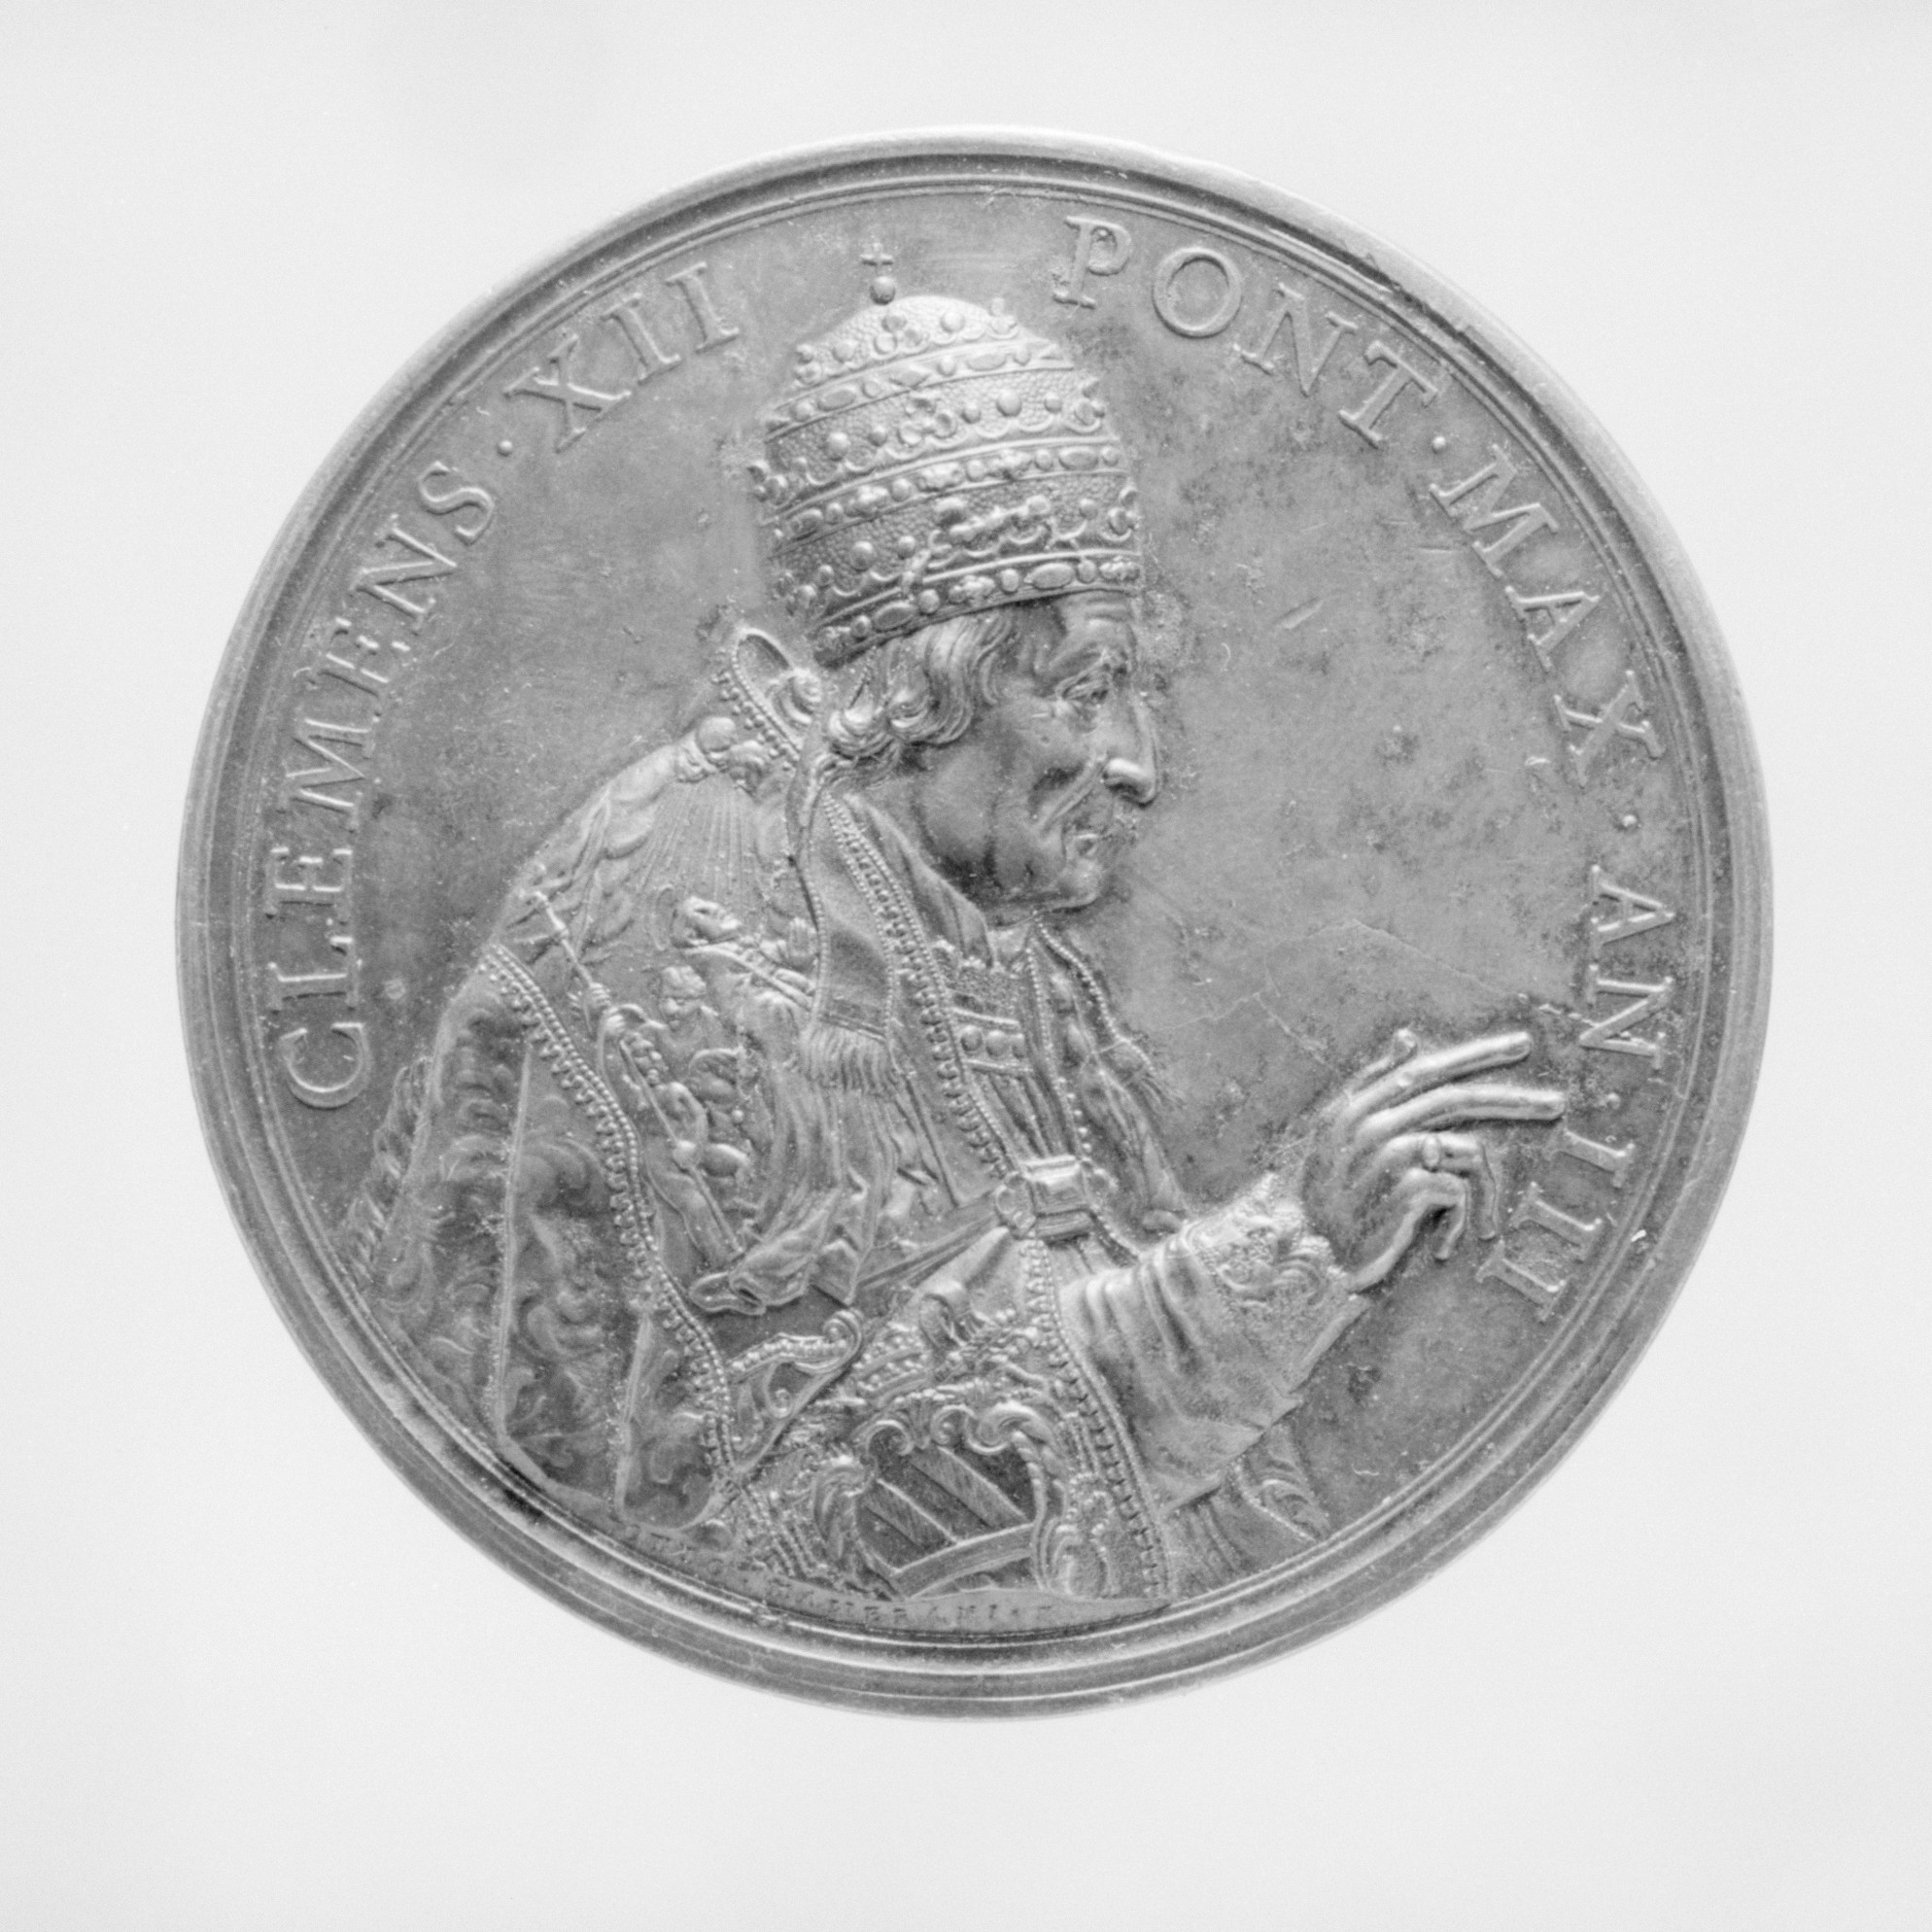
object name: medal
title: Clement XII (Lorenzo Corsini, 1652–1740, Pope 1730–60)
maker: ottone hamerani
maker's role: artist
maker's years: 1694-1768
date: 1733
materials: bronze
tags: buildings,men,profiles,popes